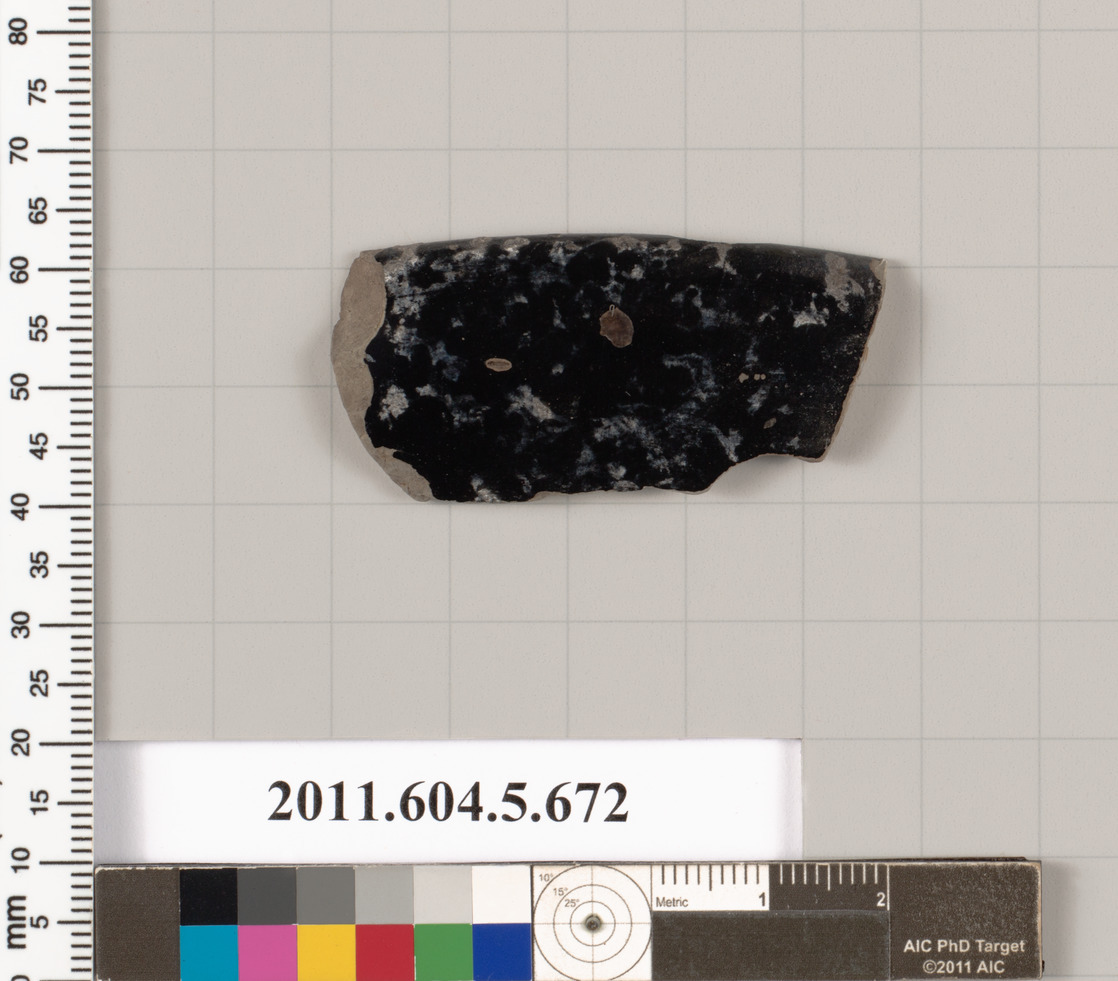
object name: kylix fragment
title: Terracotta rim fragment of a kylix (drinking cup)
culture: greek, attic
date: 600-401 BCE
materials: terracotta